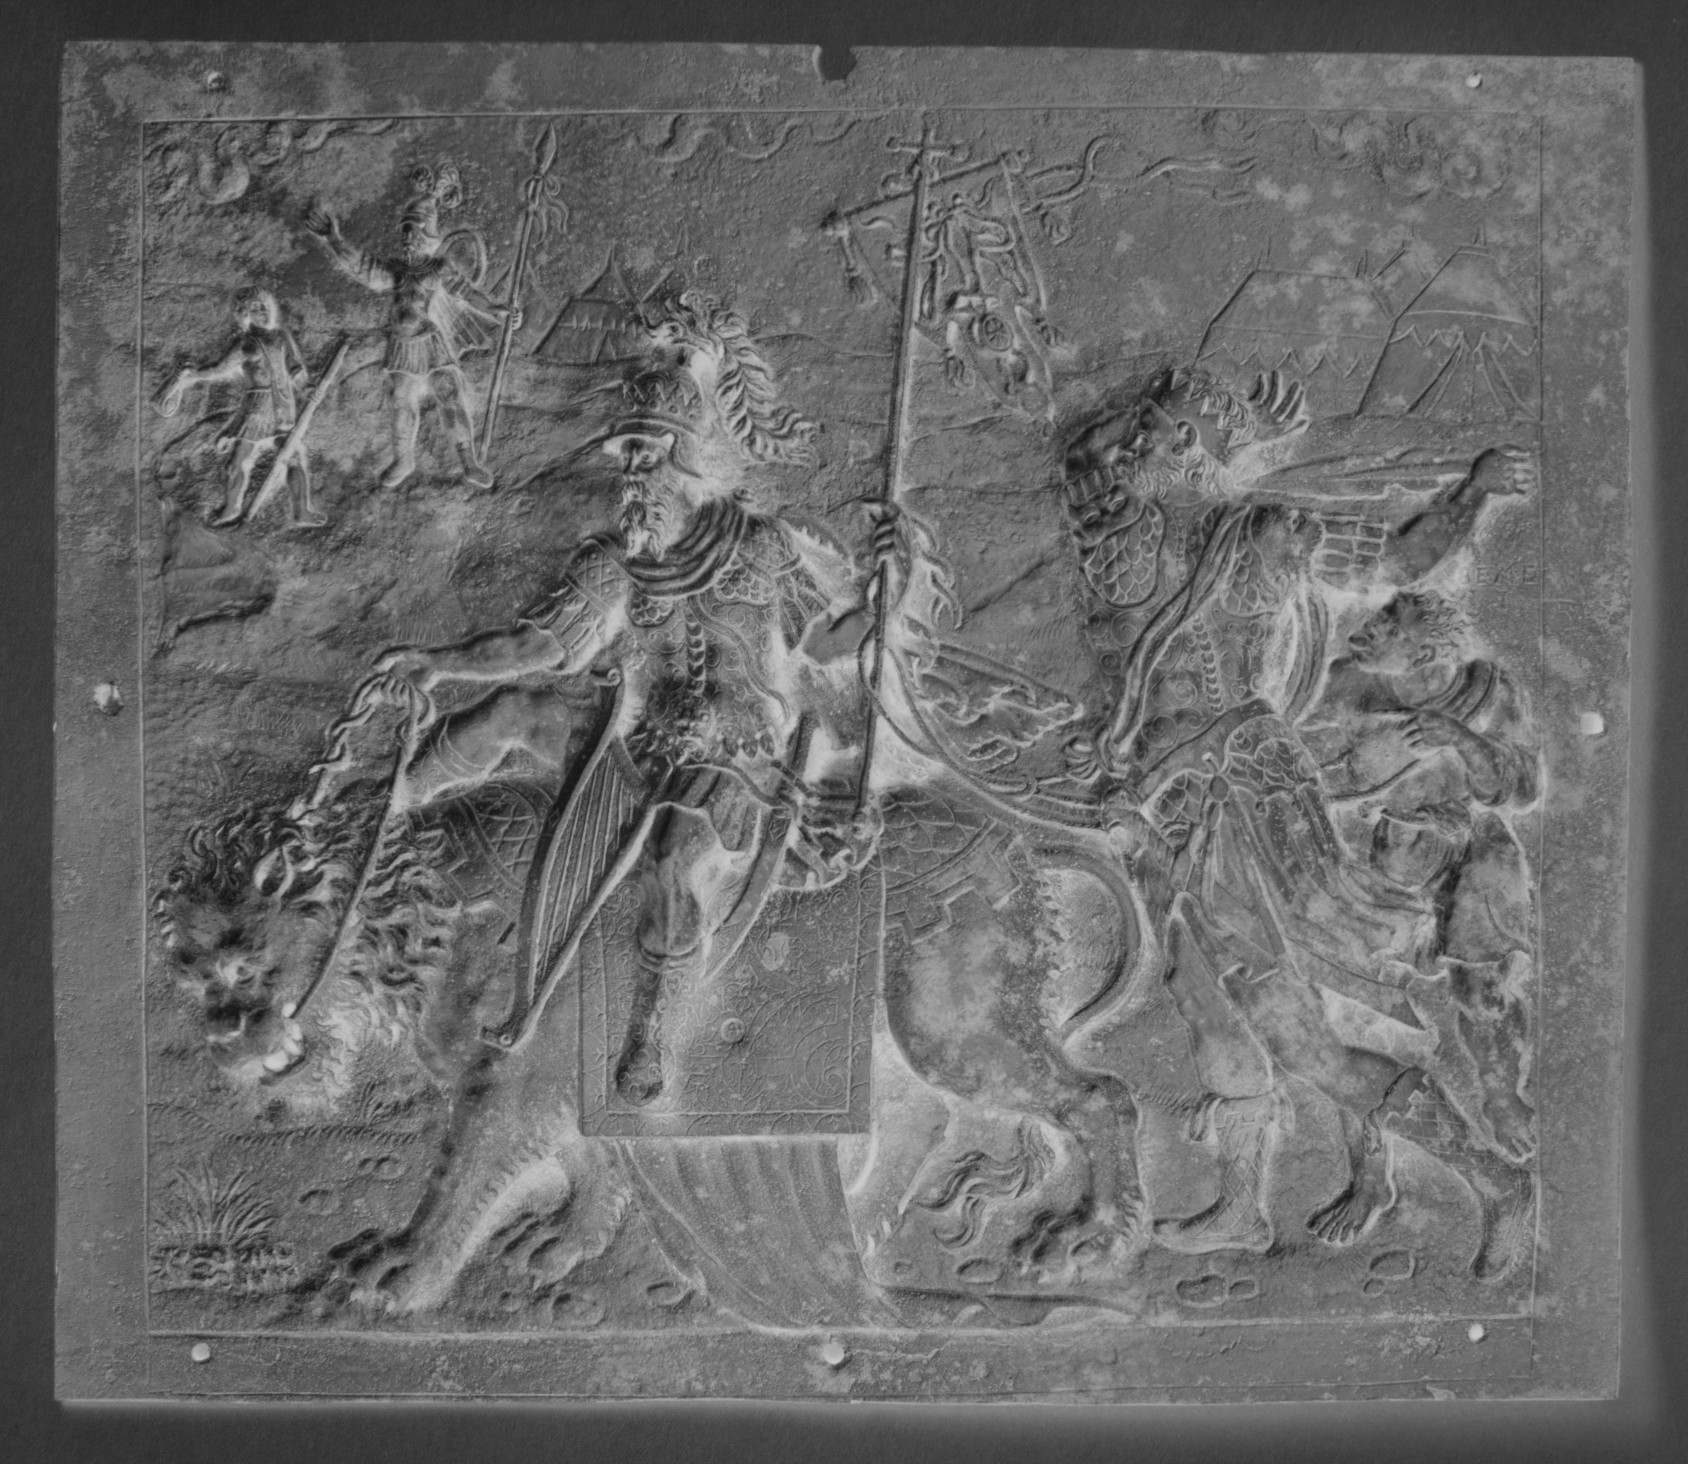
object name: plaquette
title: Allegory of David and Saul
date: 1501-1600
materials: steel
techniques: repoussé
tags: men,lions,david,allegory